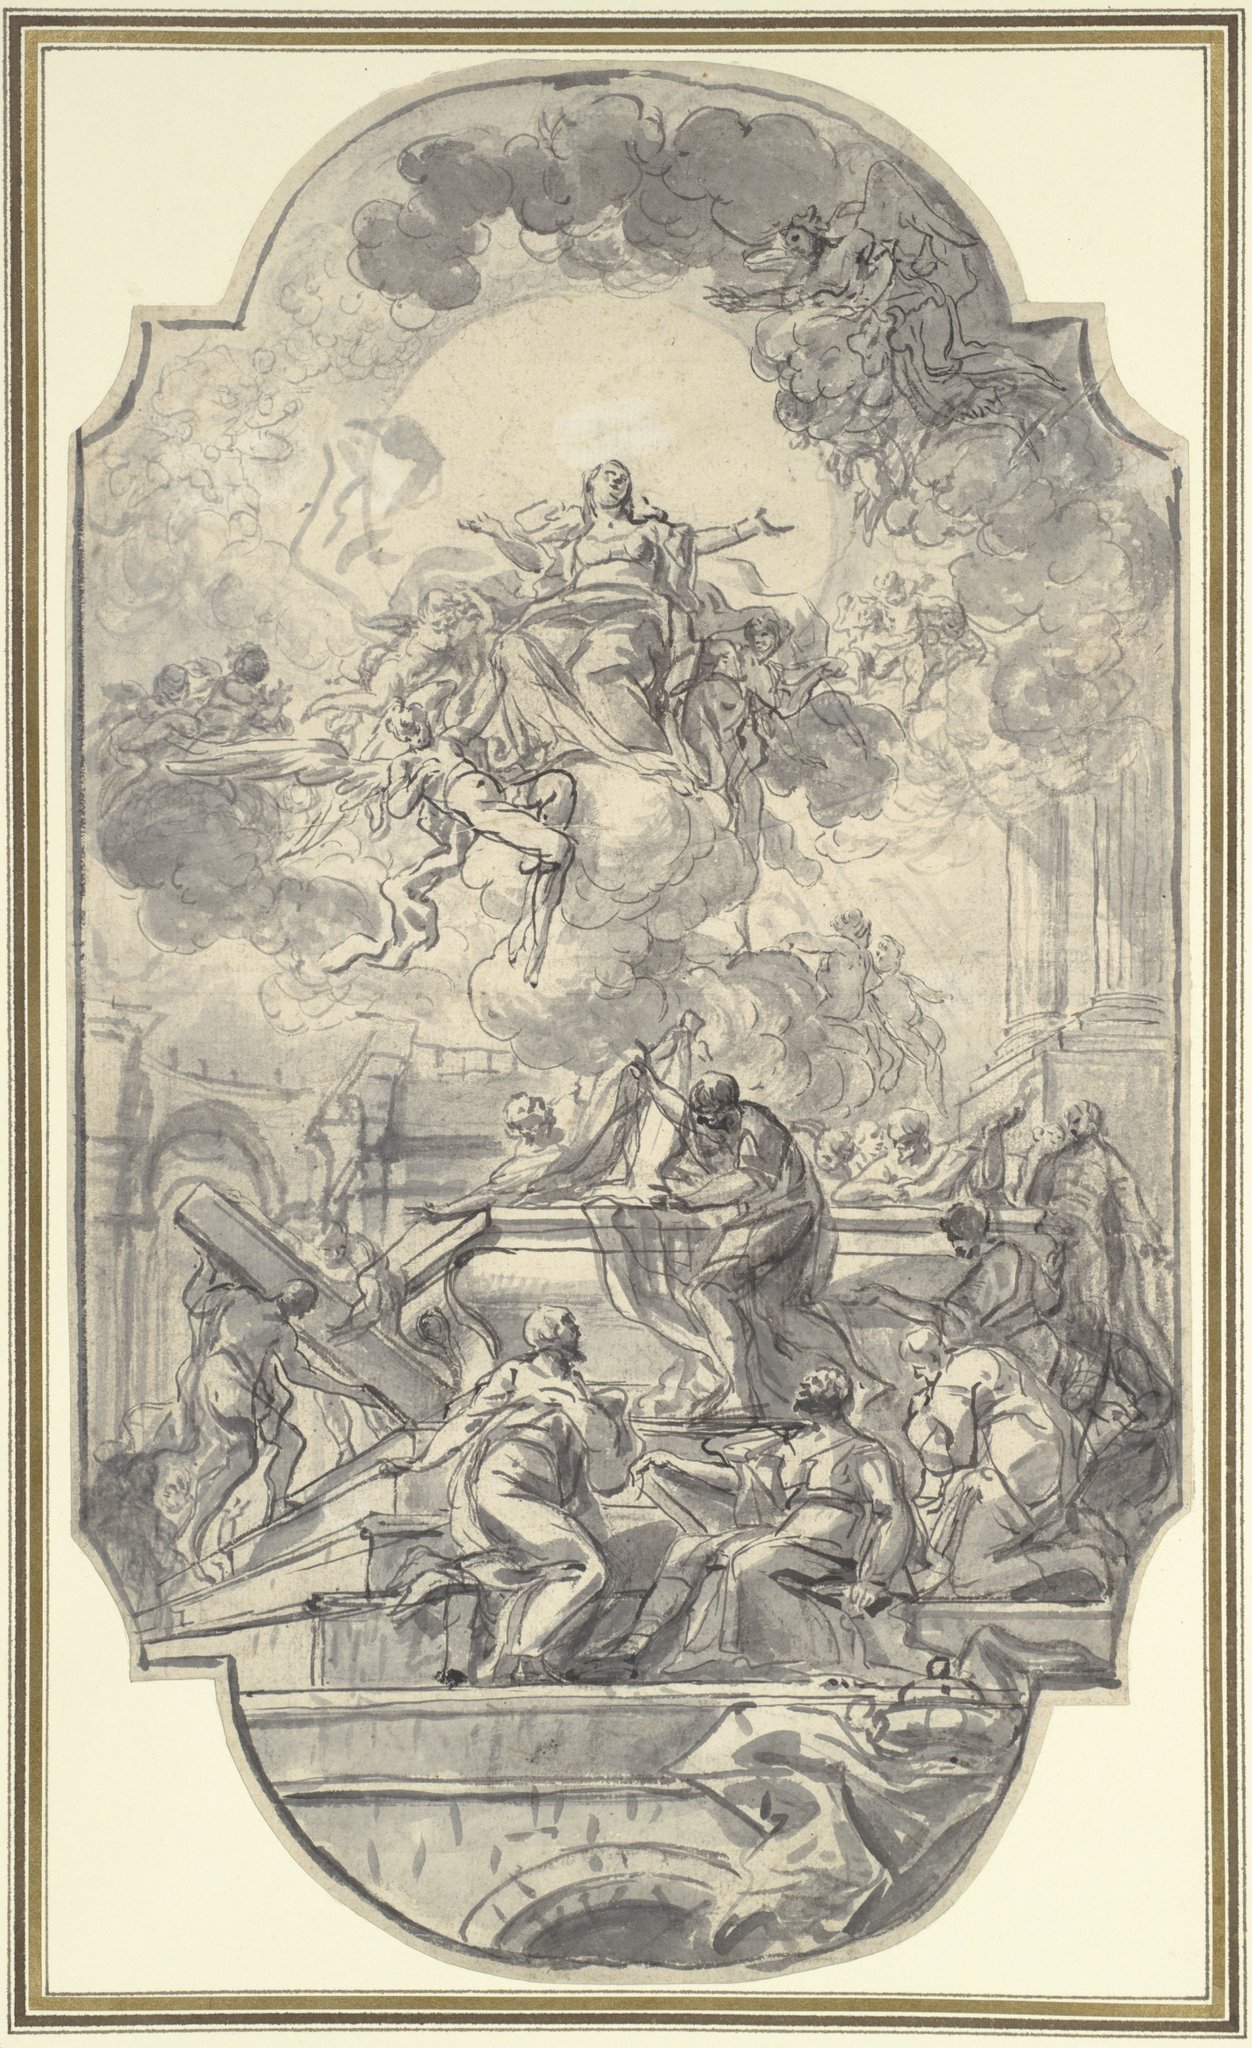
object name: drawing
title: The Assumption of the Virgin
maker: francesco de mura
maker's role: artist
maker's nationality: italian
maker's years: 1696-1782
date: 1751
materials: chalk, ink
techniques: brush, pen, wash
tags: men,angels,virgin mary,assumption of the virgin